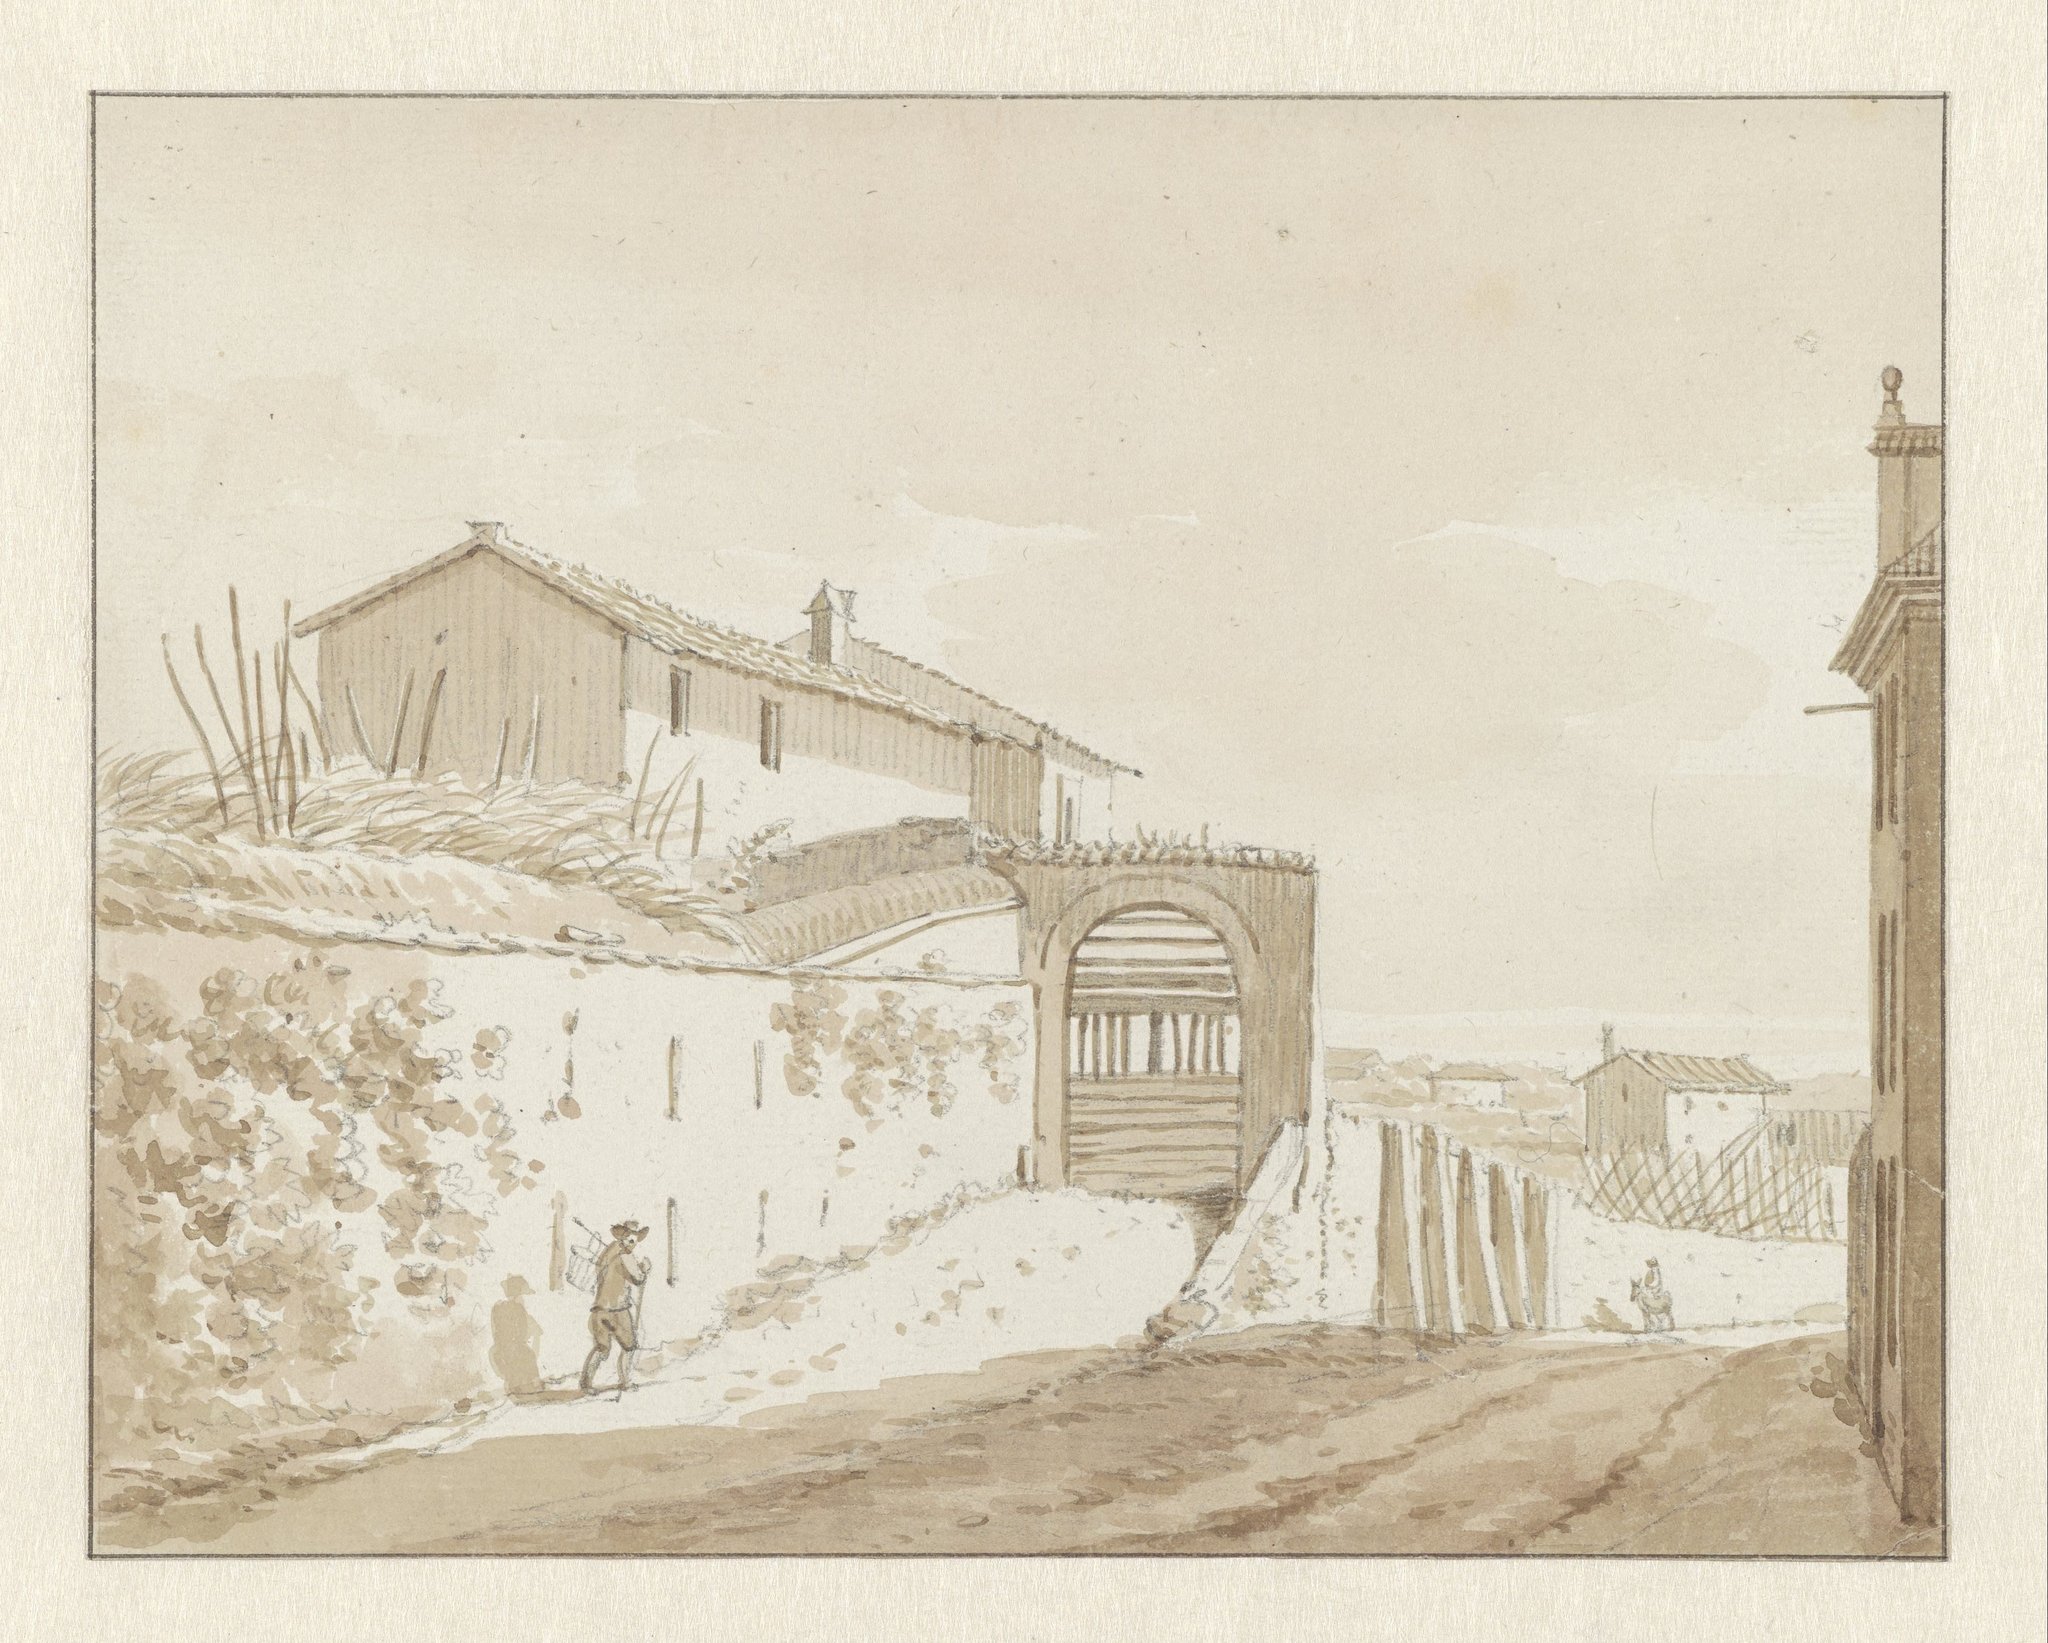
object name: drawing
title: Buiten de Porta S. Sebastiano, Rome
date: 1761-1817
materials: chalk, ink, paper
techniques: brush, pen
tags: church (exterior), city-gate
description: Tekening uit een groep tekeningen van landschappen en stadsgezichten in Italië (Rome, Tivoli, Civita Castellana en Pozzuoli).